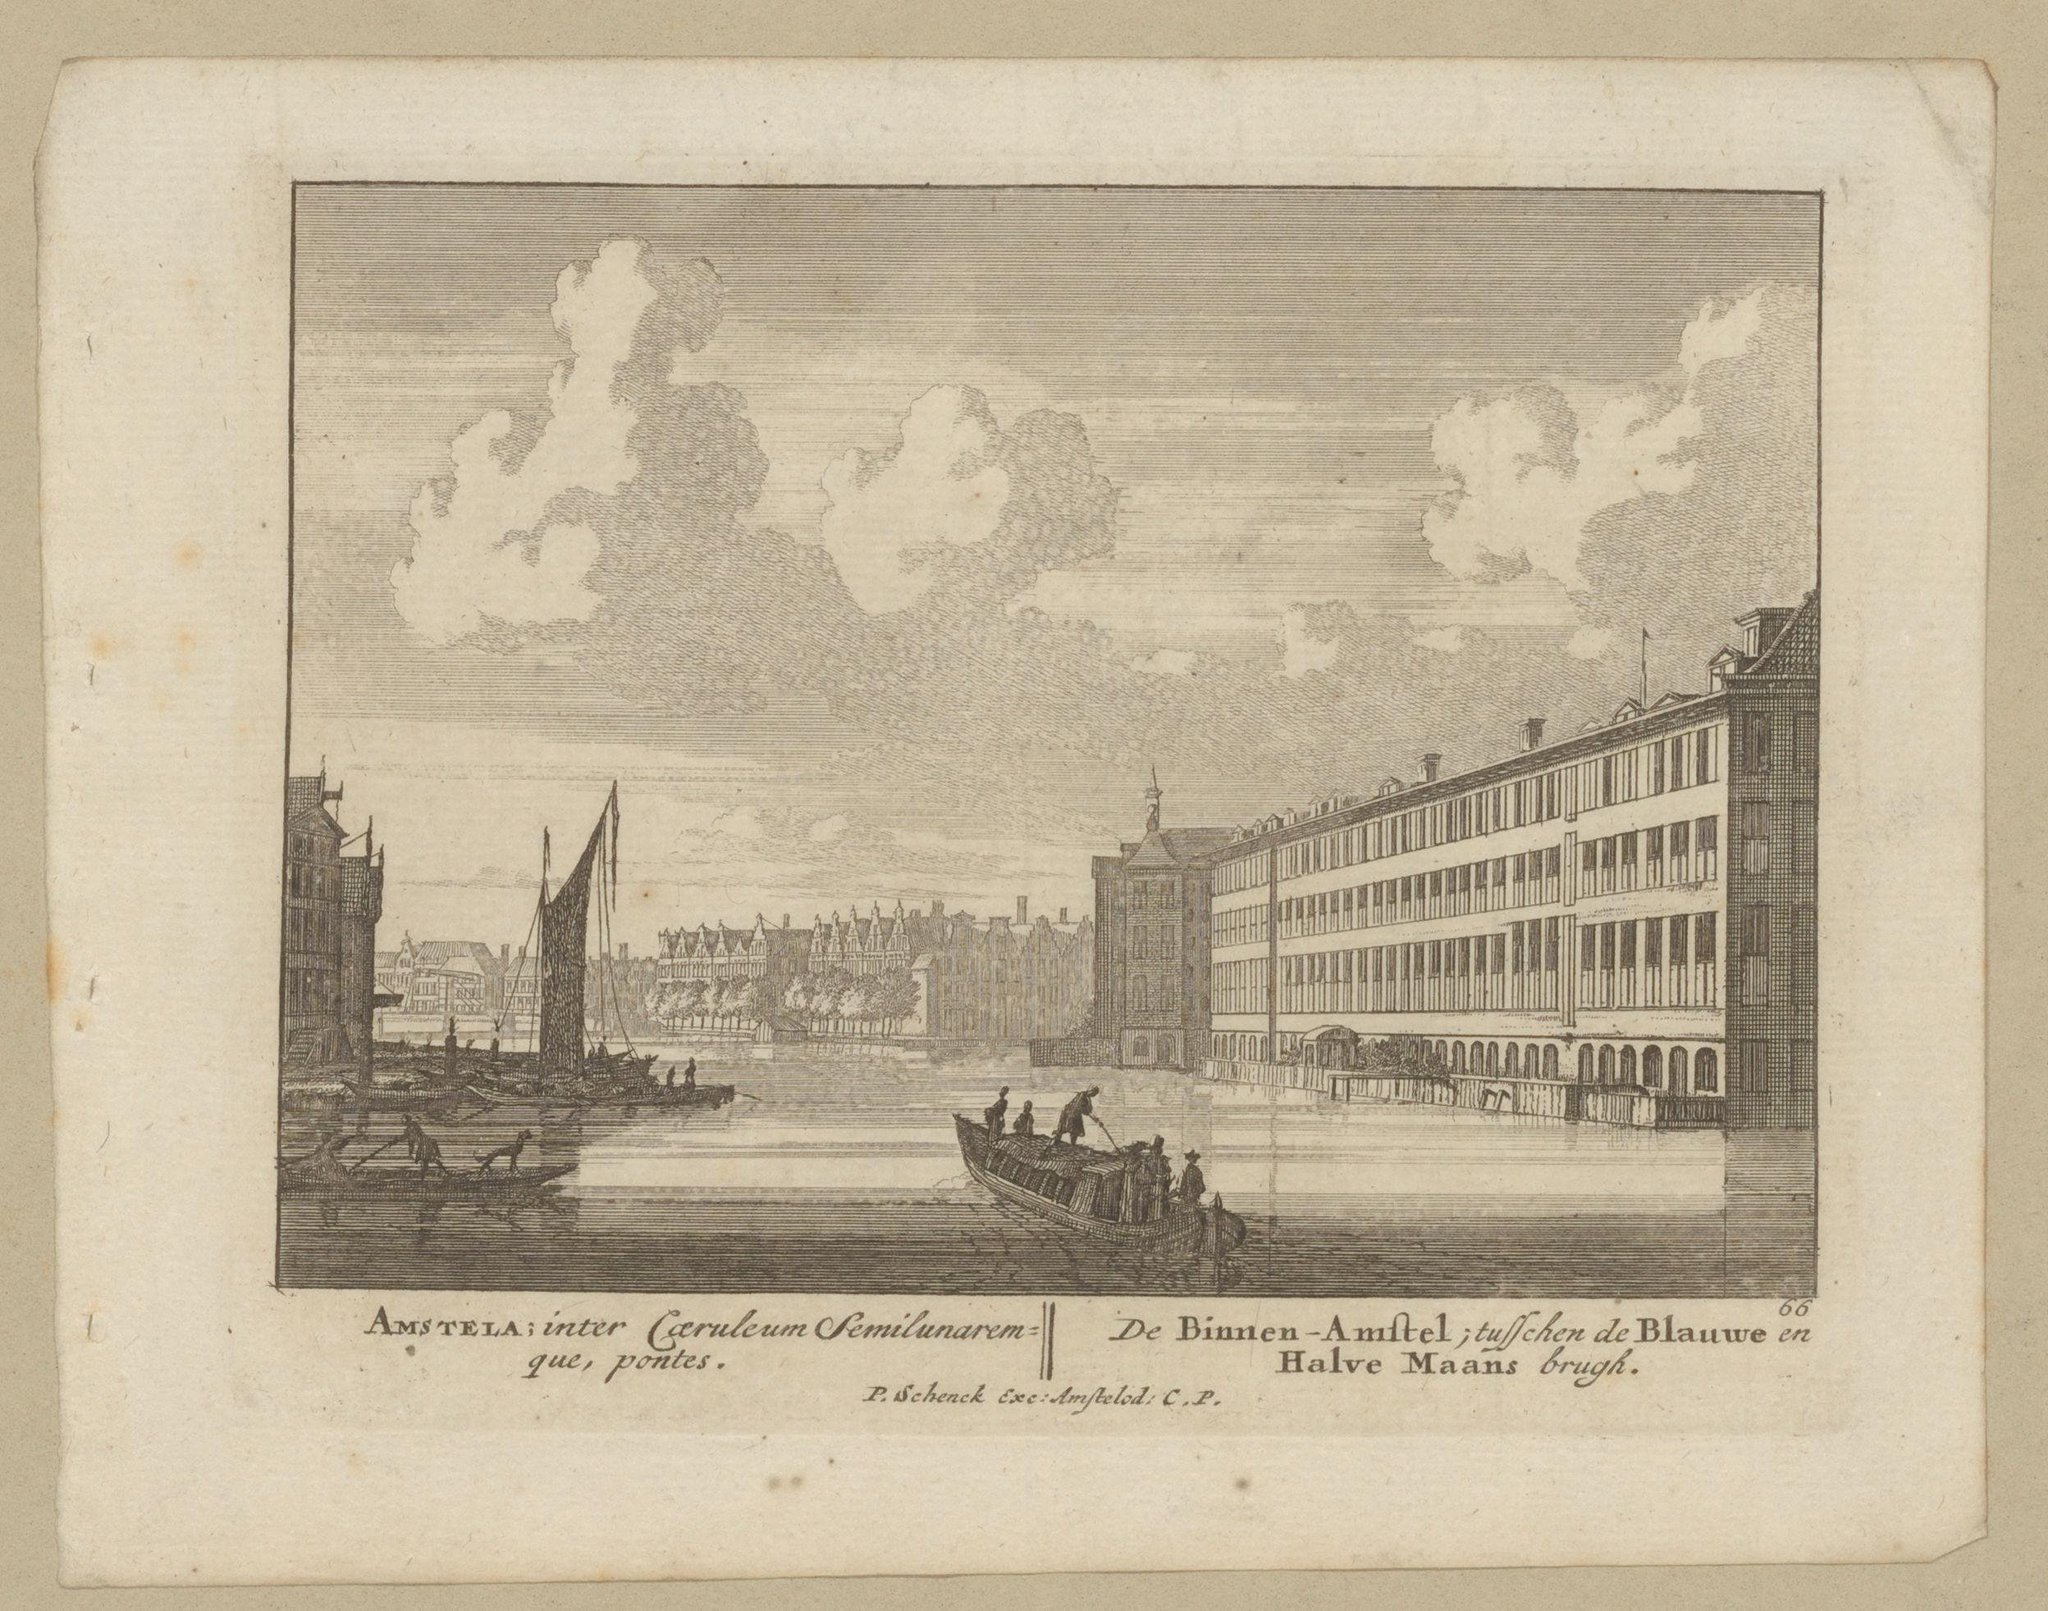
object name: print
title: Amstela inter Ceruleum Semilunaremque, pontes / De Binnen-Amstel tusschen de Blauwe en Halve Maans brugh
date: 1694-1697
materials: paper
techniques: etching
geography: amsterdam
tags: city-view in general; 'veduta', canal, bridge in city across river, canal, etc., boat propelled by man or animal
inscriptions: collector's mark: ‘4A no 40 a en b’ Lugt 1641b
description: Prent uit: Admirandorum Quadruplex Spectaculum. Amsterdam: Pieter Schenk (I), [1694-1697]. In Hollstein vermeld bij een serie van 100 prenten over Amsterdam, maar de prenten die in Hollstein worden genoemd zijn groter.